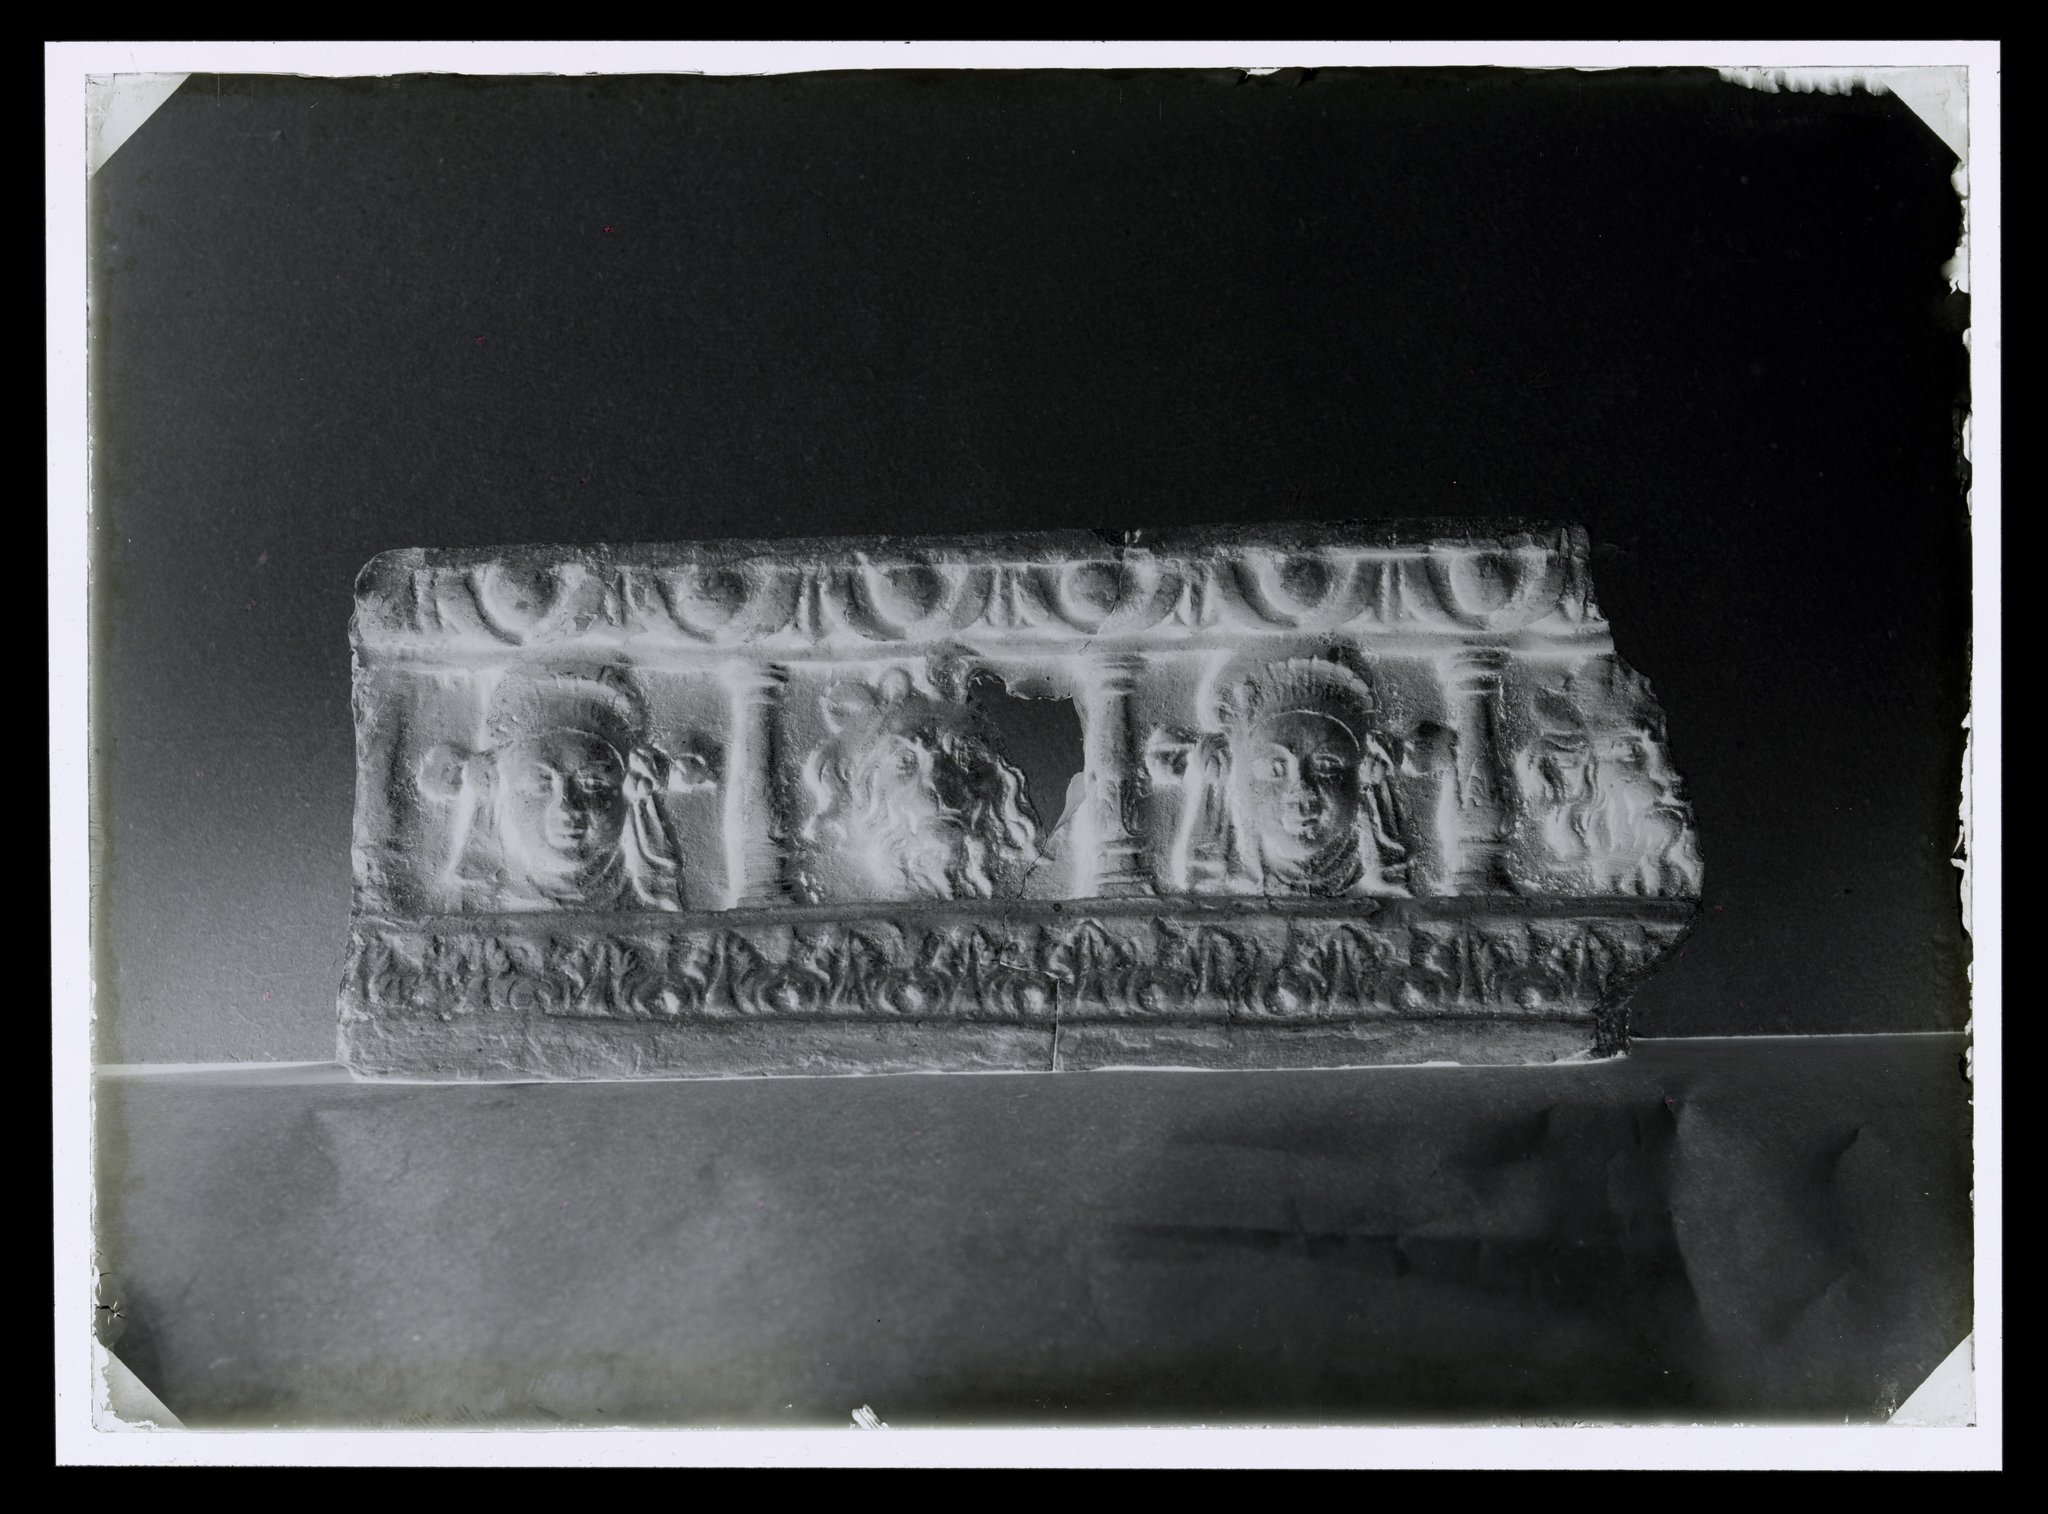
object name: glasnegatief, glasplaatnegatief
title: Architecturaal ornament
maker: laurens lodewijk kleijn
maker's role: draughtsman, painter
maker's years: 1826-1909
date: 1865-1900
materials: glass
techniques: collodion process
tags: ornament derived from architectural details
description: Onderdeel van een groep glasnegatieven uit de nalatenschap van de schilder Laurens Lodewijk Kleijn, met stillevens, portretten, zelfportretten en kunstreproducties.